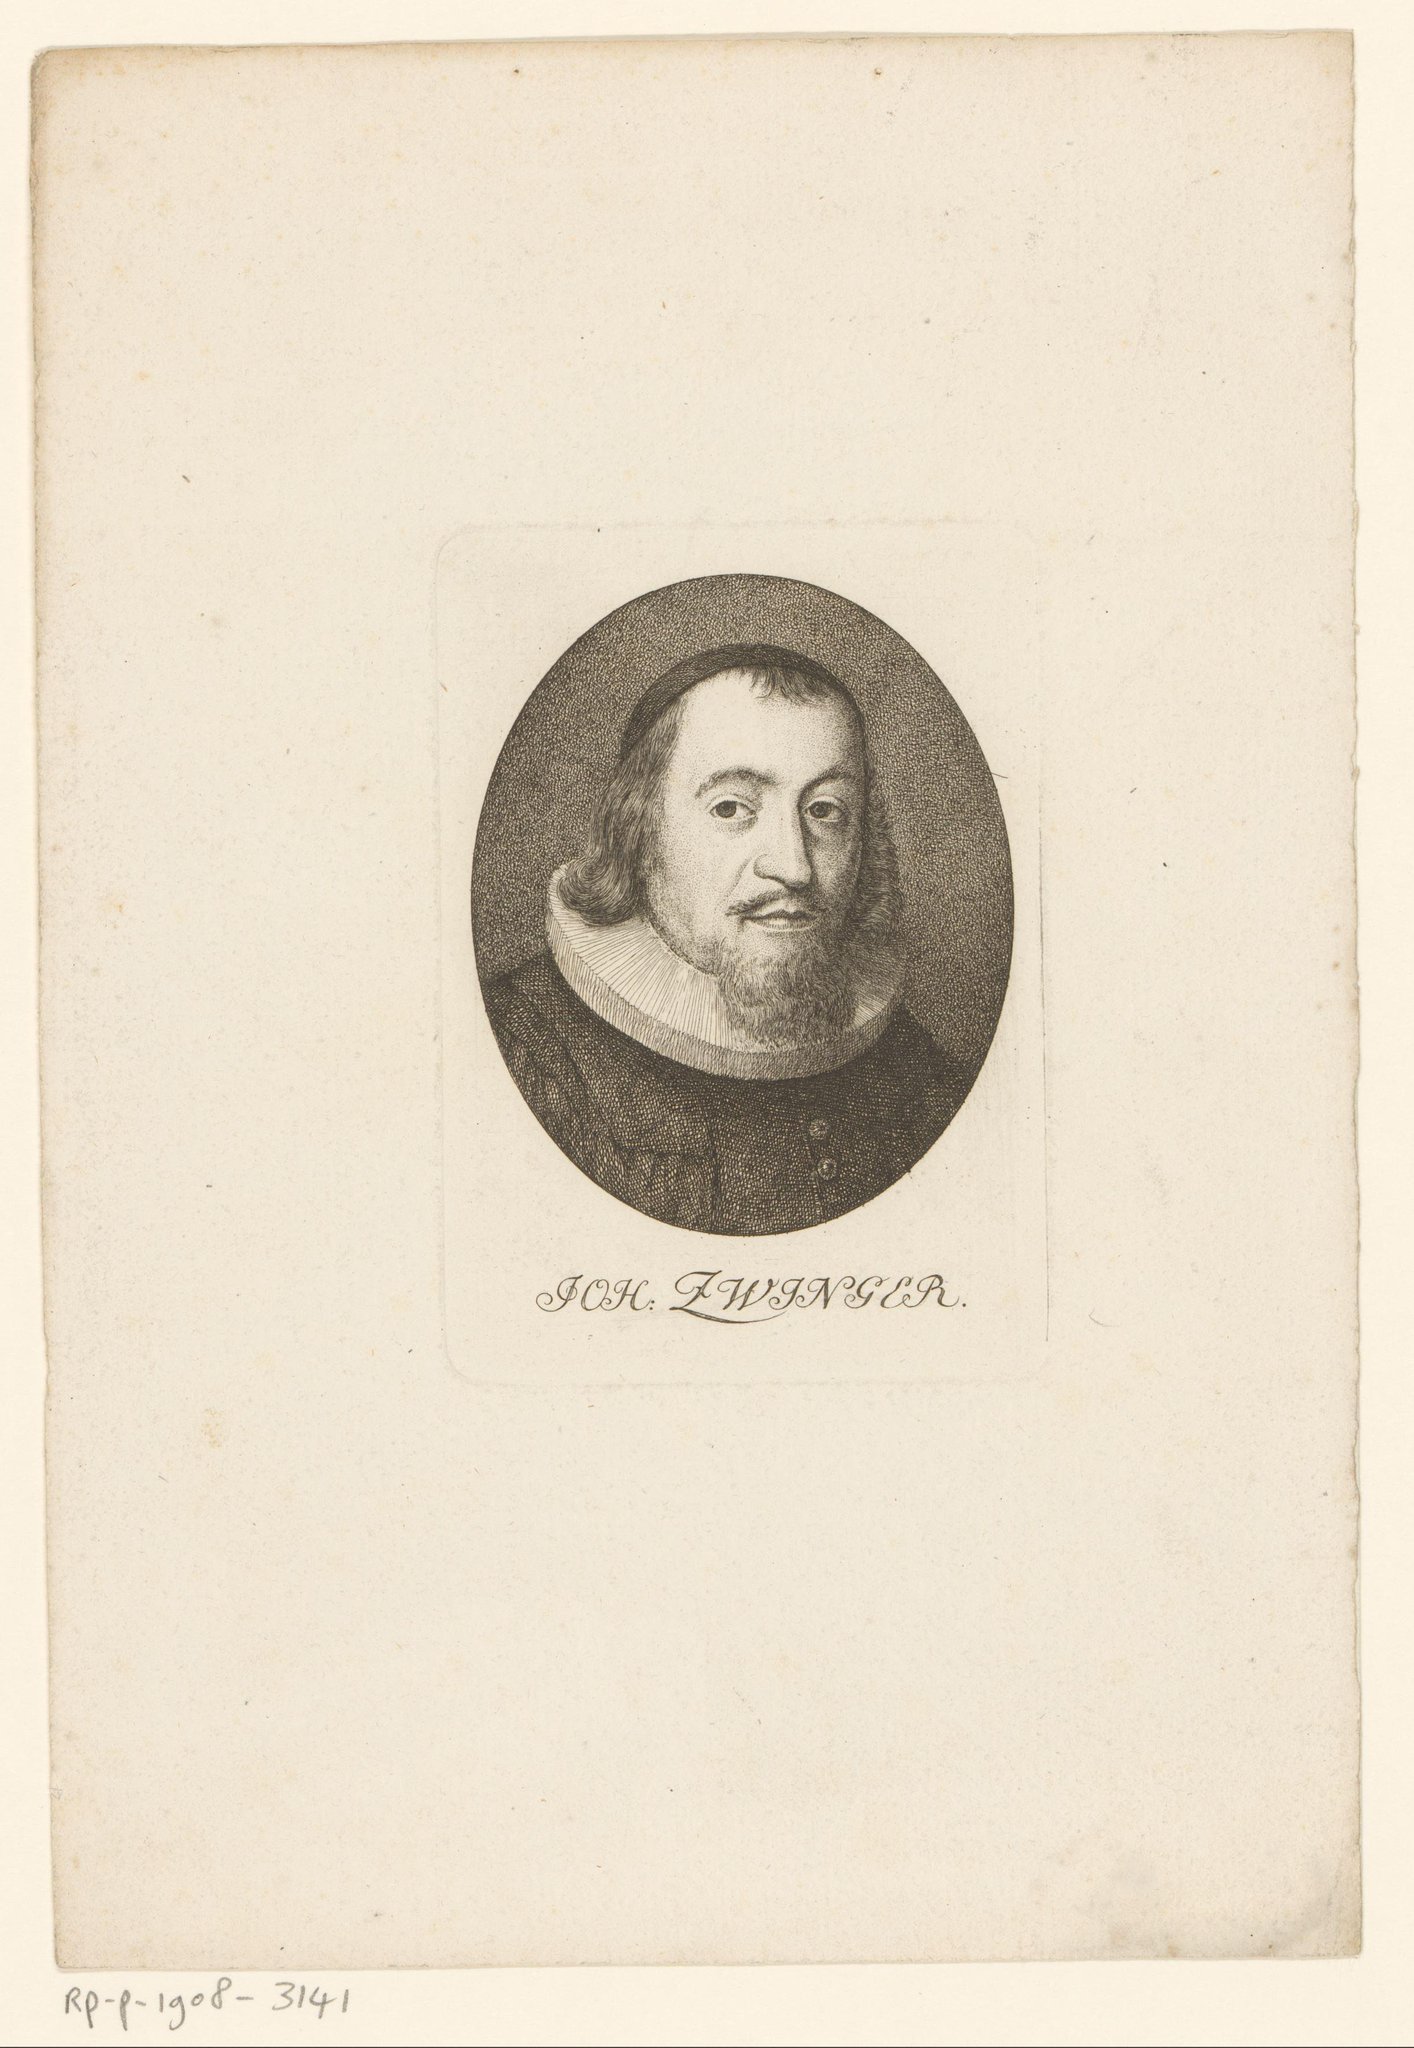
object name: print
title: Portret van Johann Zwinger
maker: heinrich pfenninger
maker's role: print maker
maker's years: 1749-1815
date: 1759-1815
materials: paper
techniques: etching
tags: historical persons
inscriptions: collector's mark: Lugt 2228